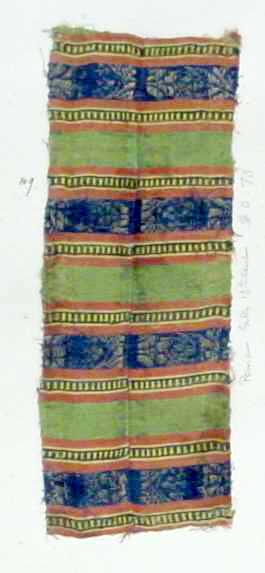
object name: textile fragment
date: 1701-1800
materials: silk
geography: iran